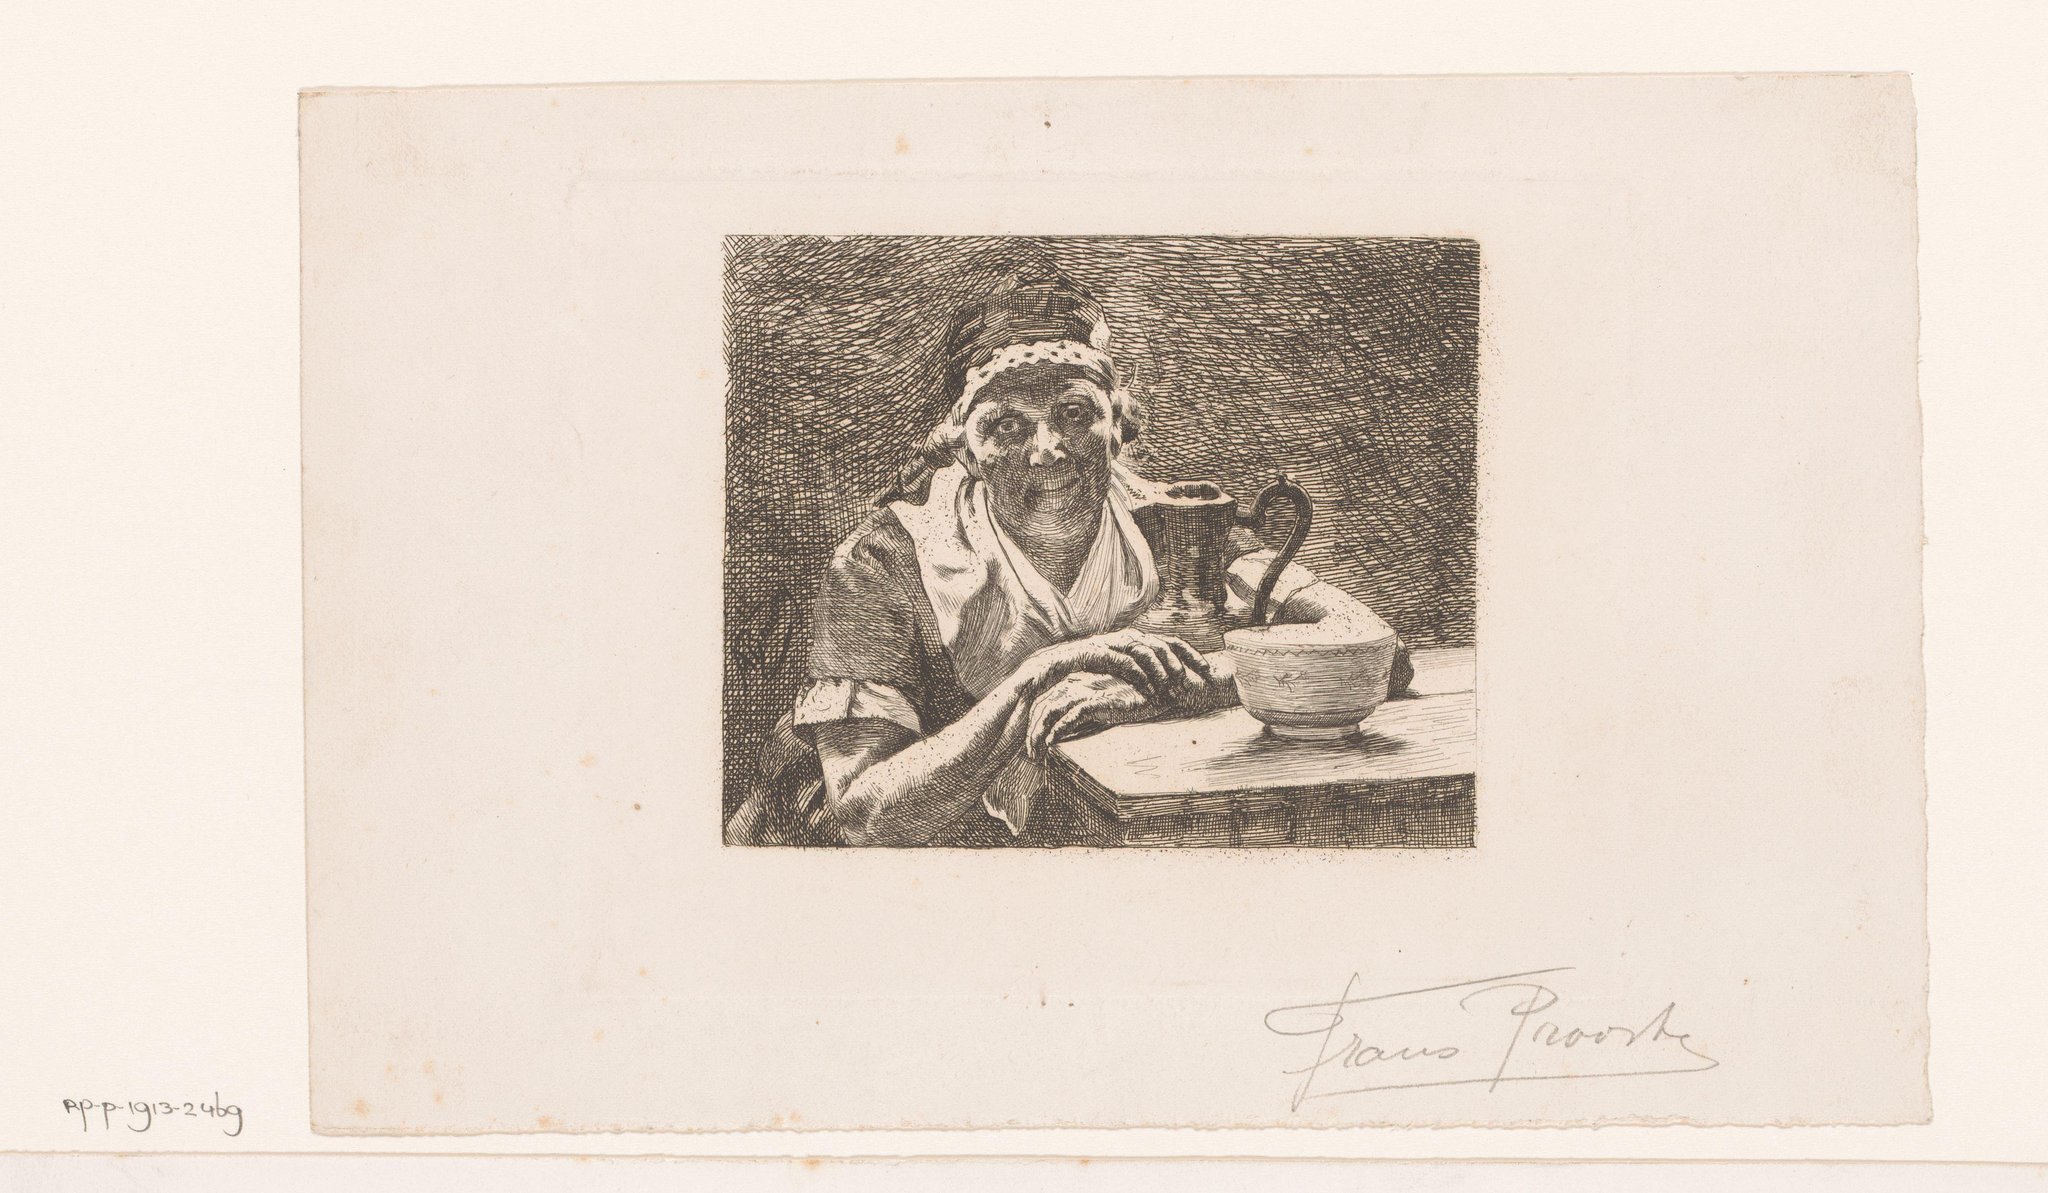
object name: print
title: Oude vrouw aan tafel met kan en kom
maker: frans proost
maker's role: painter, print maker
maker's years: 1875-1941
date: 1885-1913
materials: paper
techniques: etching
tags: old woman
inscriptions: collector's mark: Lugt 2228